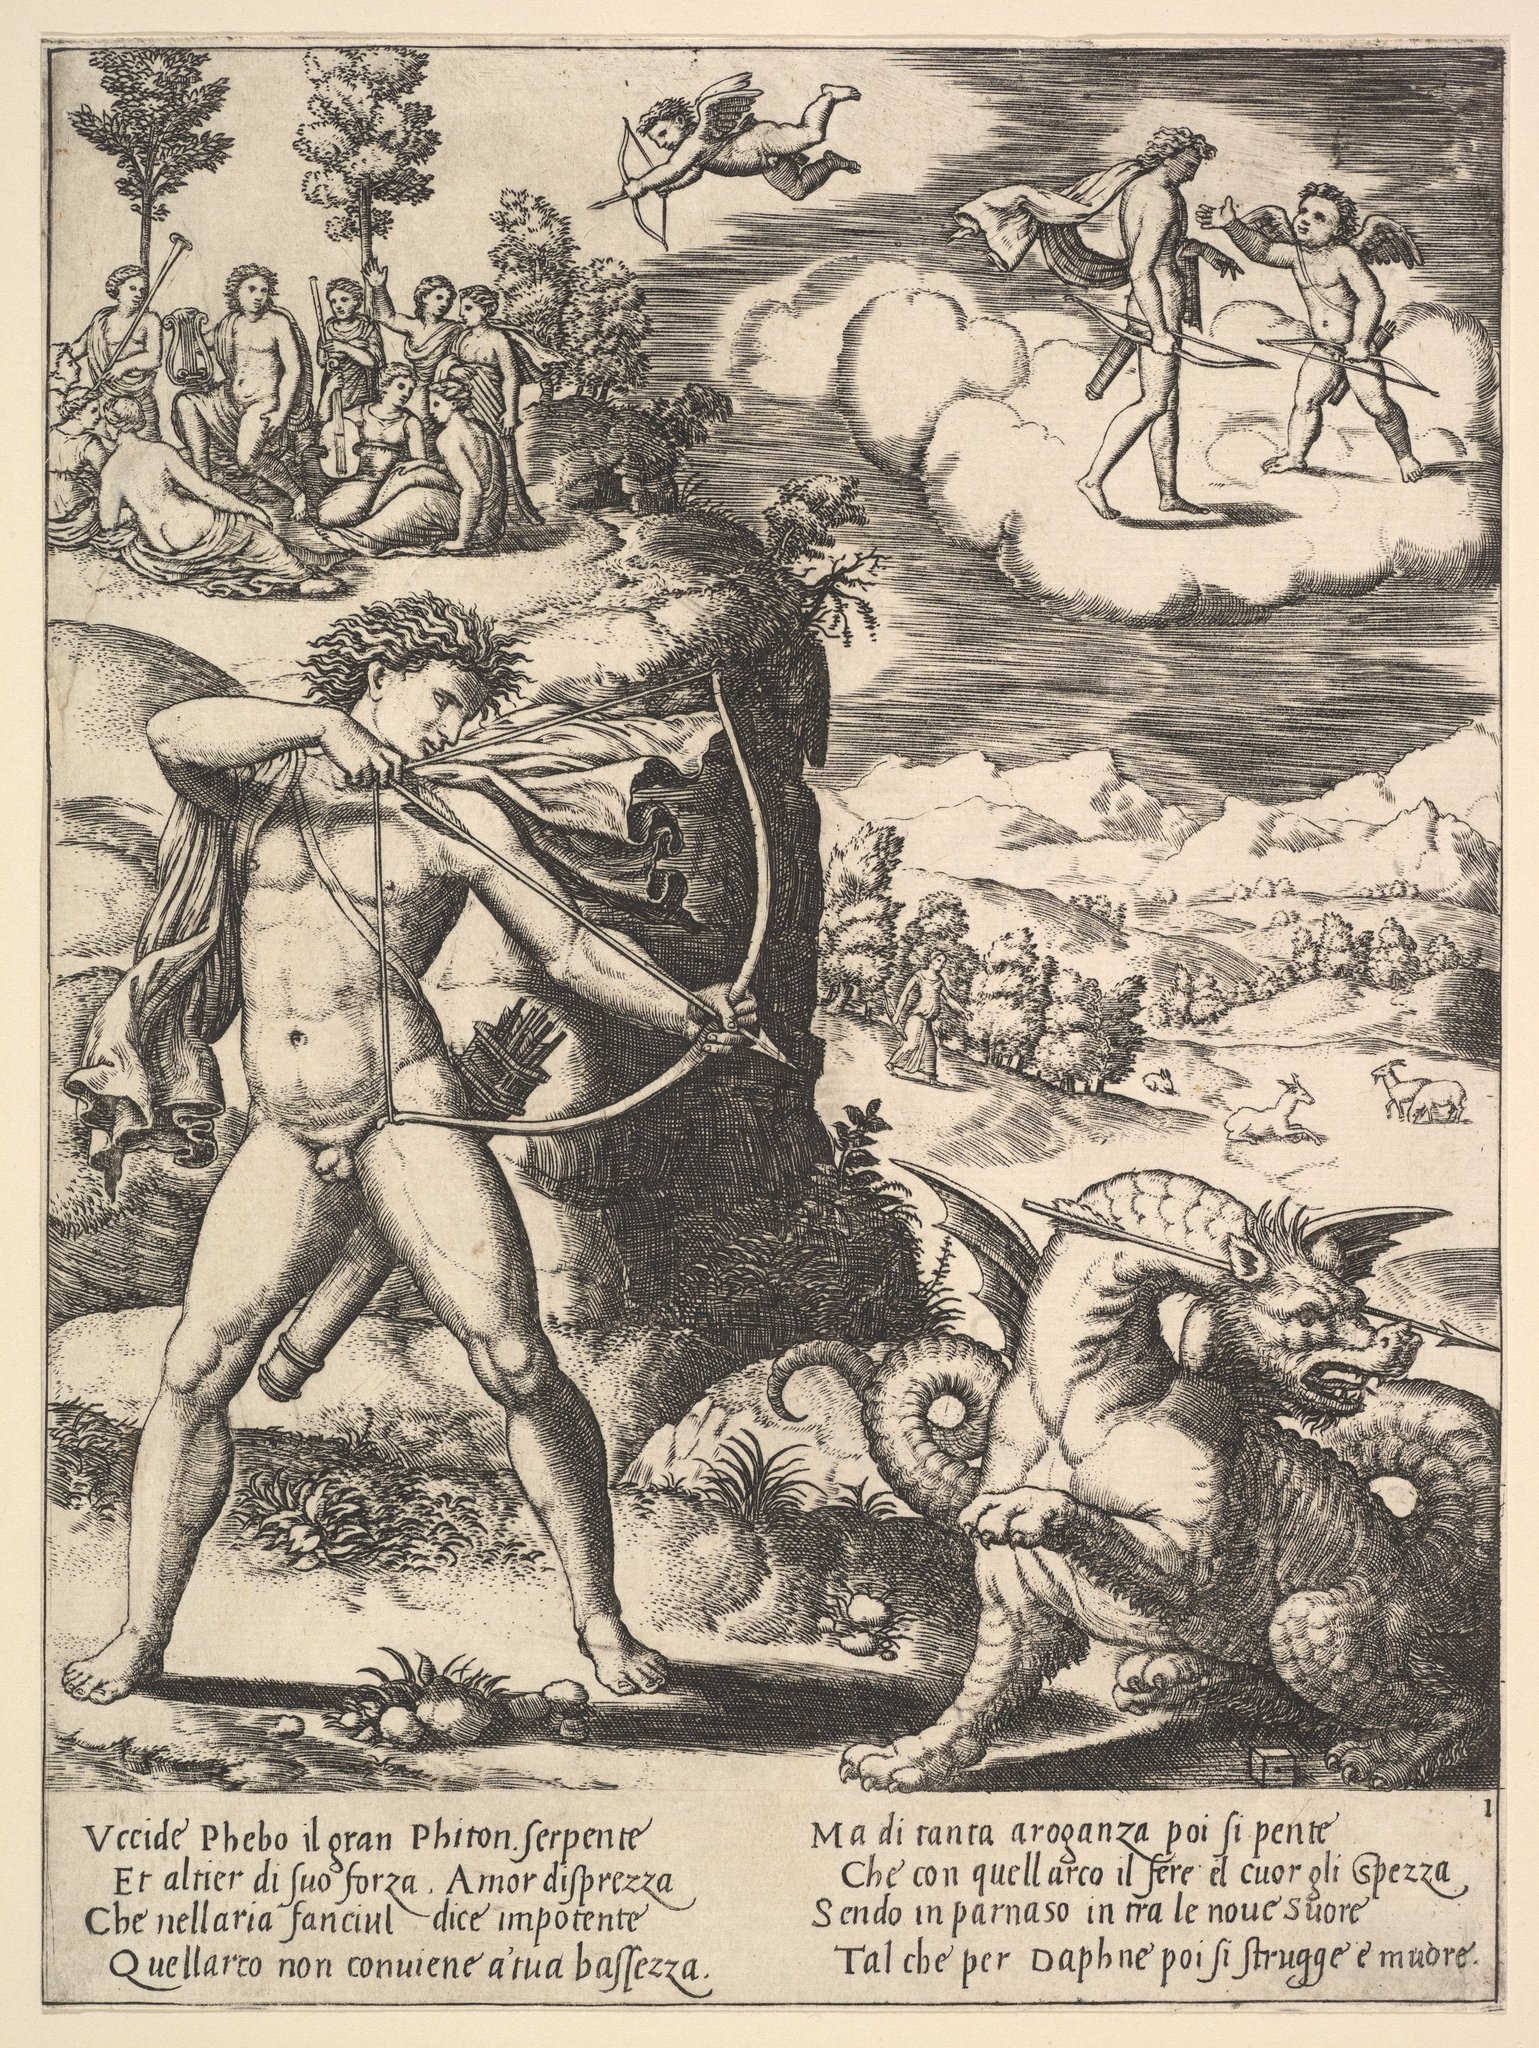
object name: print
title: Apollo standing at left shooting a python with an arrow, above to the left are the muses and at right on a cloud Cupid approaching Apollo, from "Story of Apollo and Daphne"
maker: master of the die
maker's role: artist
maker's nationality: italian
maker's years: 1525-1560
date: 1530-1560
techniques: engraving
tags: bow and arrow,male nudes,cupid,apollo,dragons